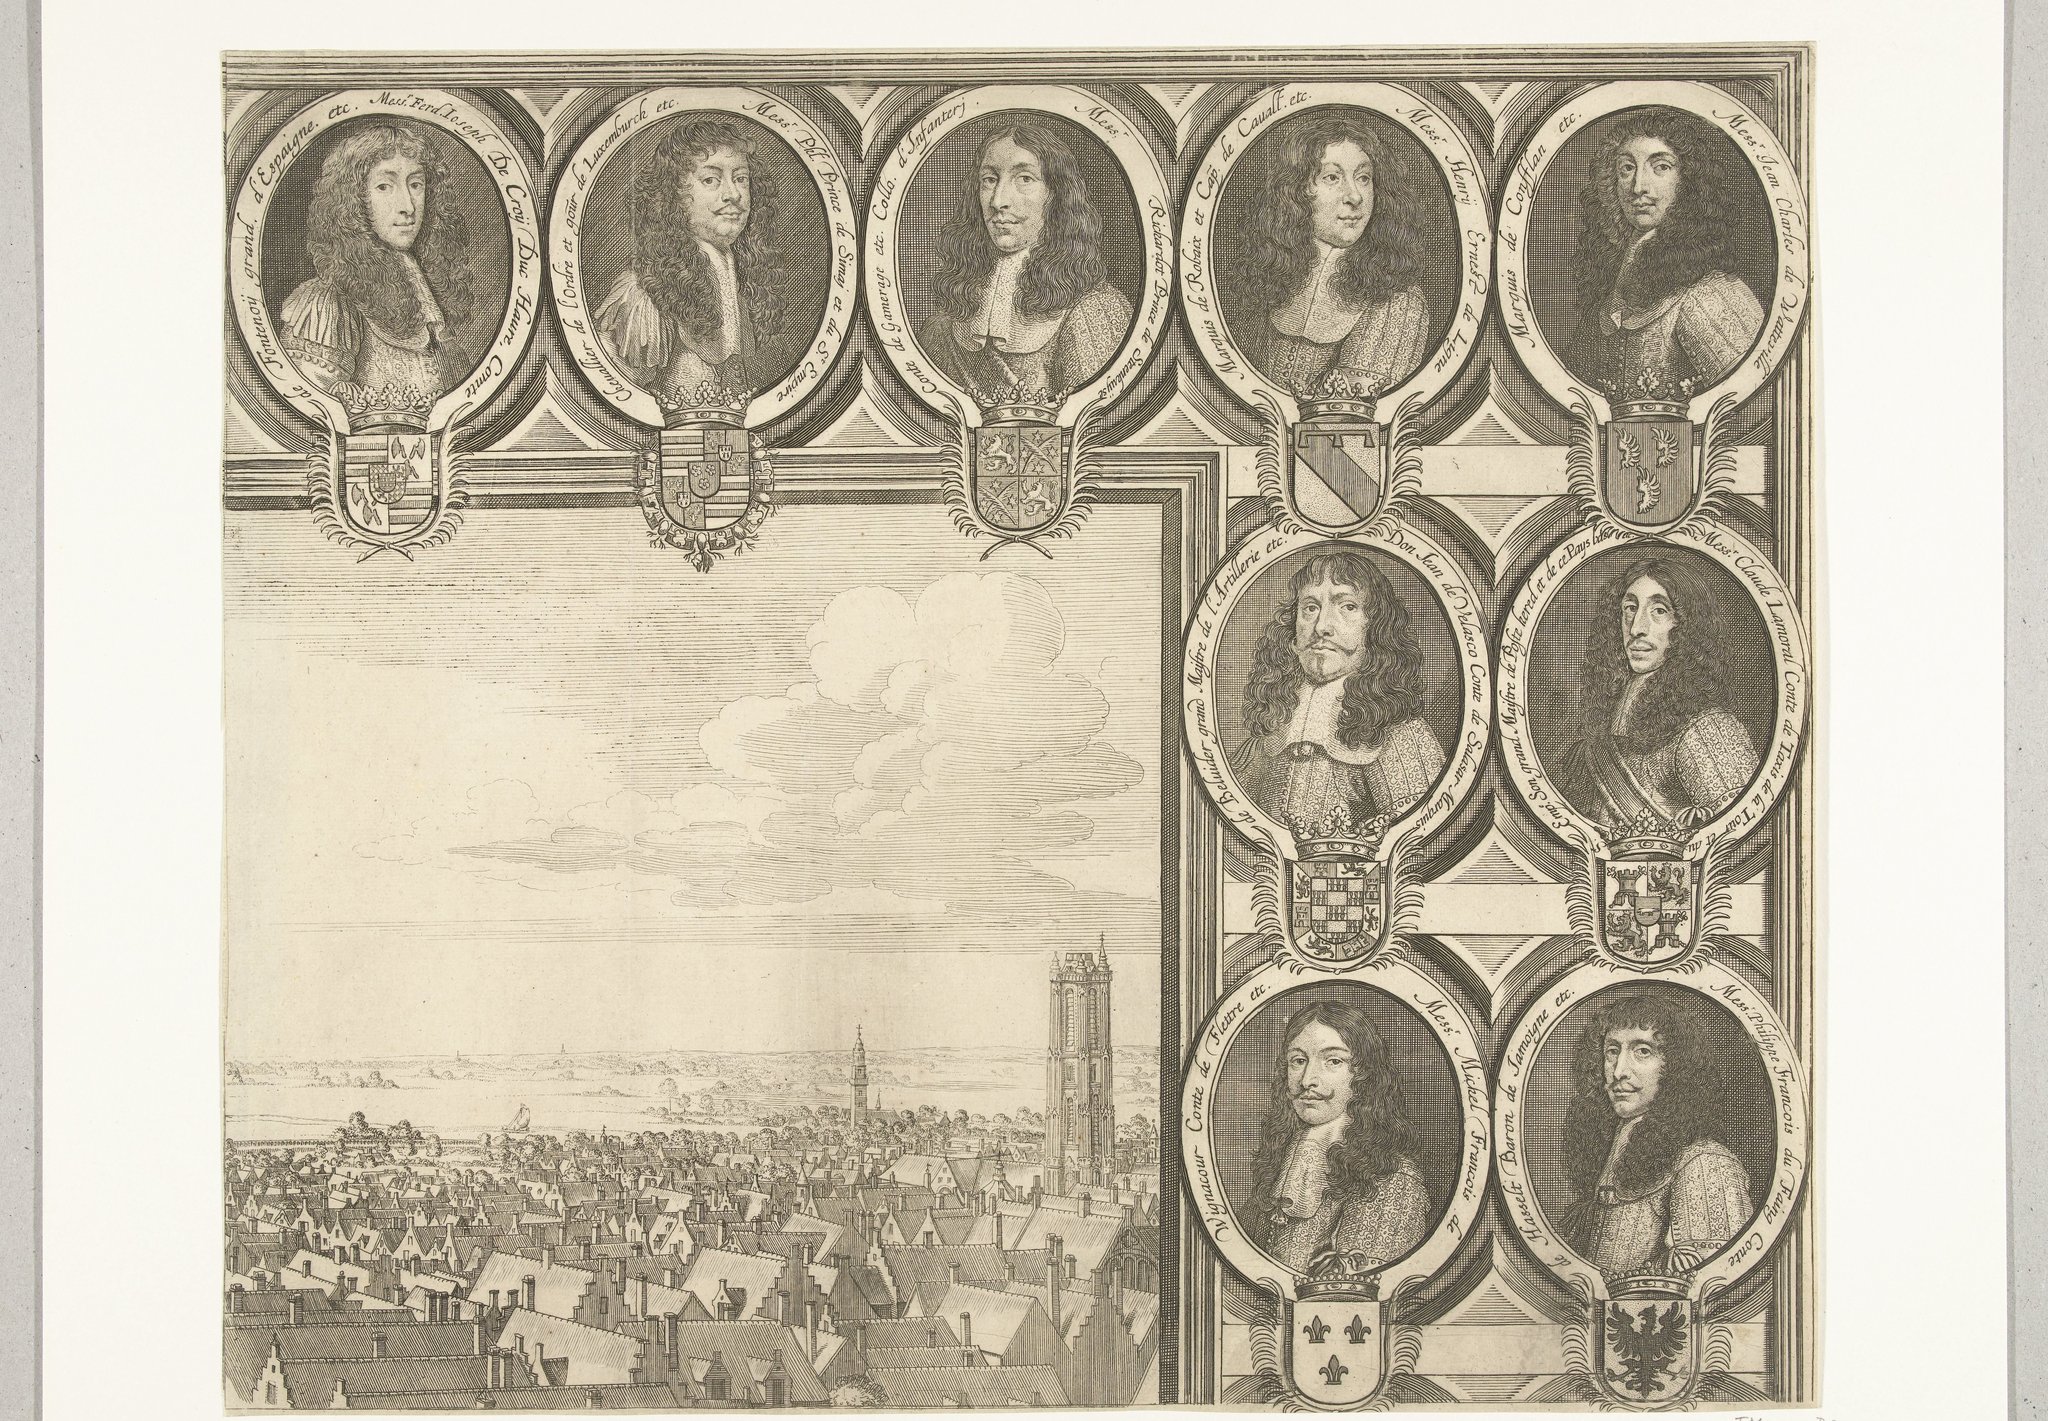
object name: print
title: Proclamatie te Gent van Karel II van Spanje als graaf van Vlaanderen (blad 3), 1666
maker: lucas vorsterman (ii)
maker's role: print maker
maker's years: 1624-1667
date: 1666-1667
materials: paper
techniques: engraving, etching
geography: southern netherlands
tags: karel ii (koning van spanje), ceremonial procession, parade, pageant ~ installation of a ruler, festivities (+ parade, pageant, cavalcade ~ festive activities)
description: Ceremonie op de Vrijdagmarkt te Gent bij de proclamatie van de Spaanse koning Karel II als graaf van Vlaanderen, 2 mei 1666. Blad 3 in een ongemonteerde ensemble van 12 platen van de ceremonie en cavalcade op het plein en 118 portretten van de hoogwaardigheidsbekleders die bij de plechtigheid aanwezig waren.